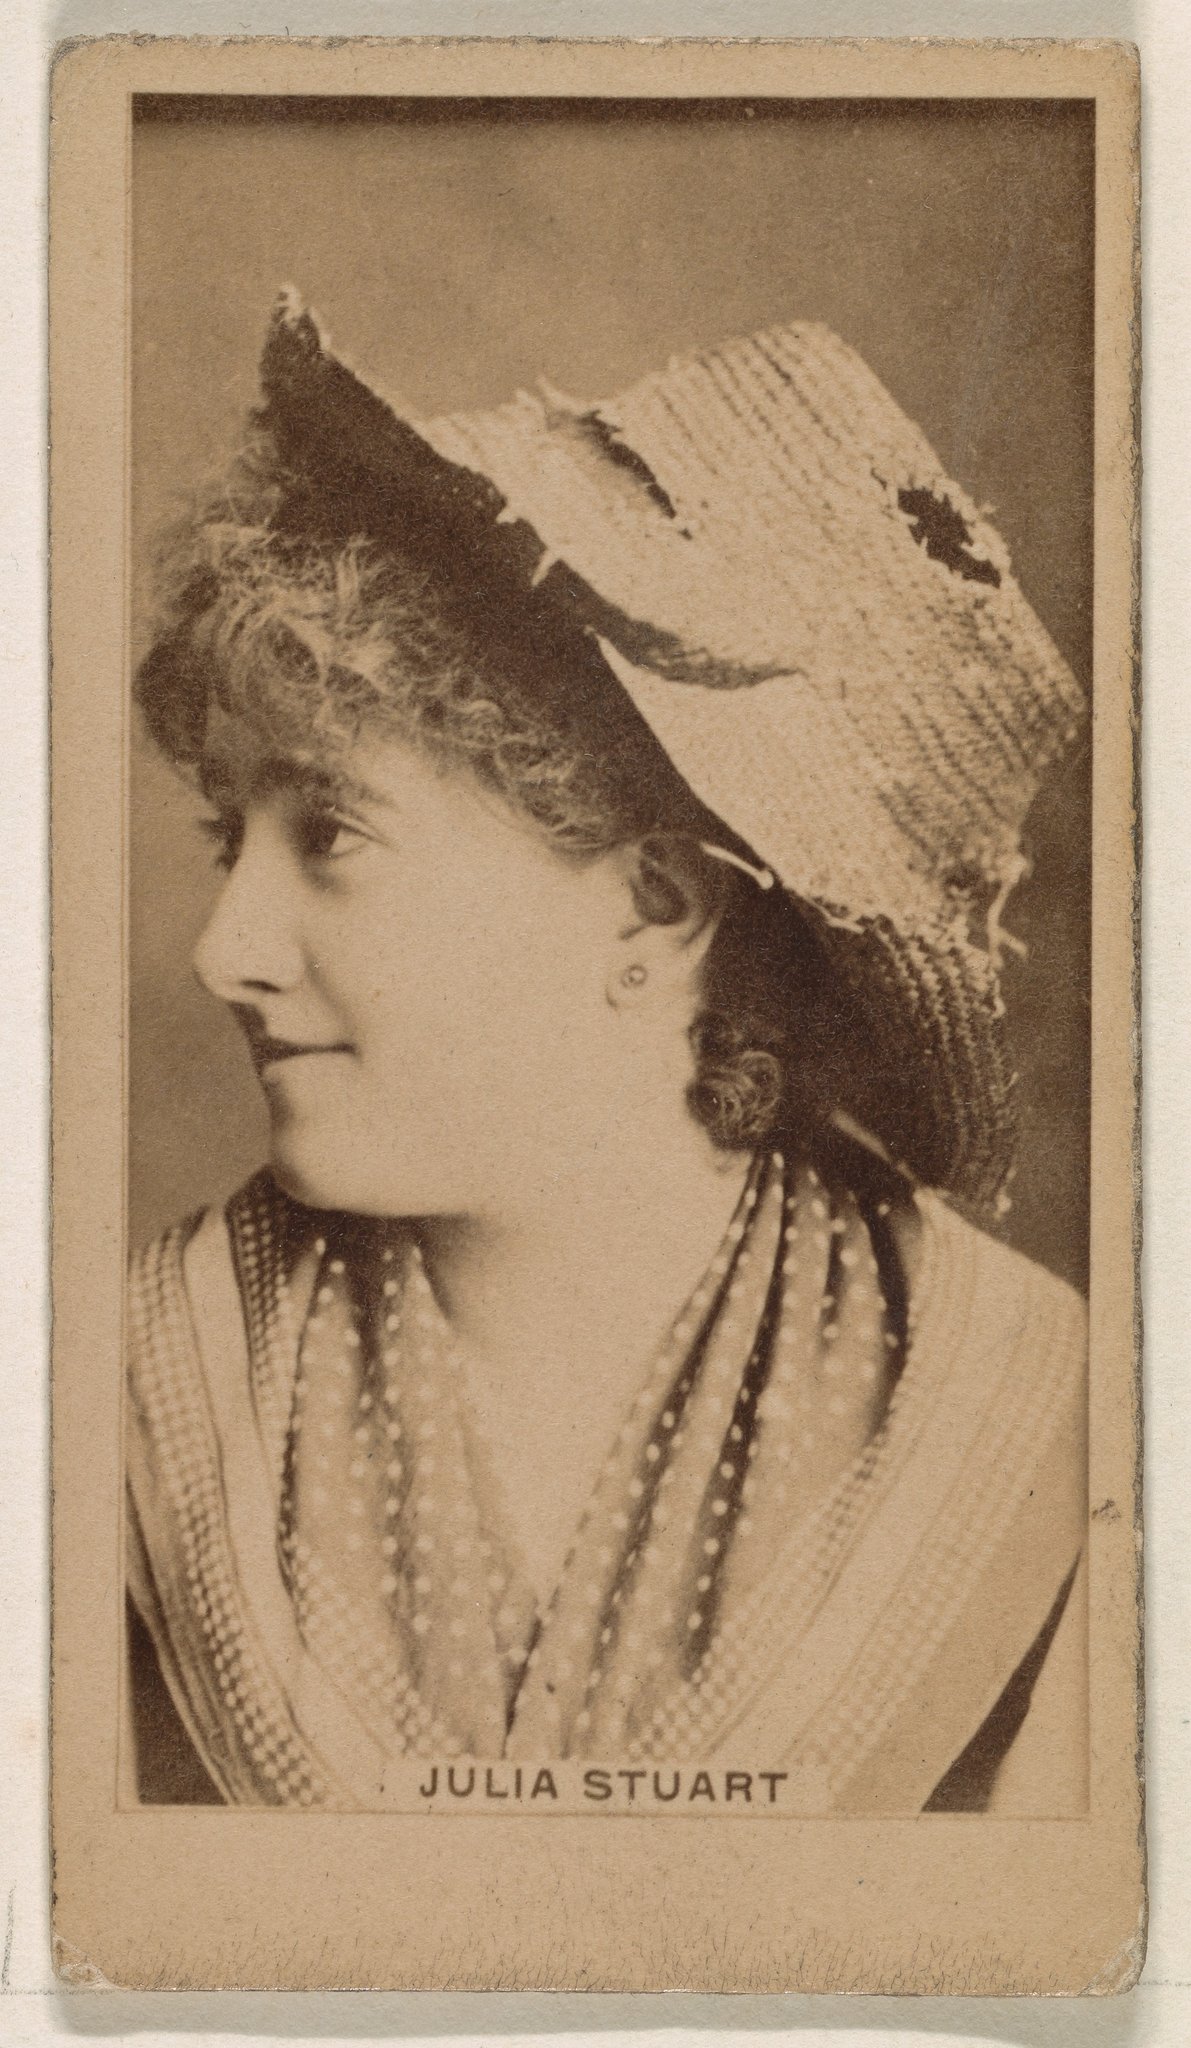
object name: photograph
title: Julia Stuart, from the Actresses series (N245) issued by Kinney Brothers to promote Sweet Caporal Cigarettes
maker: kinney brothers tobacco company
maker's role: publisher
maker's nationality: american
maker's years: 1869-2011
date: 1890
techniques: albumen silver print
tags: portraits,women,actresses